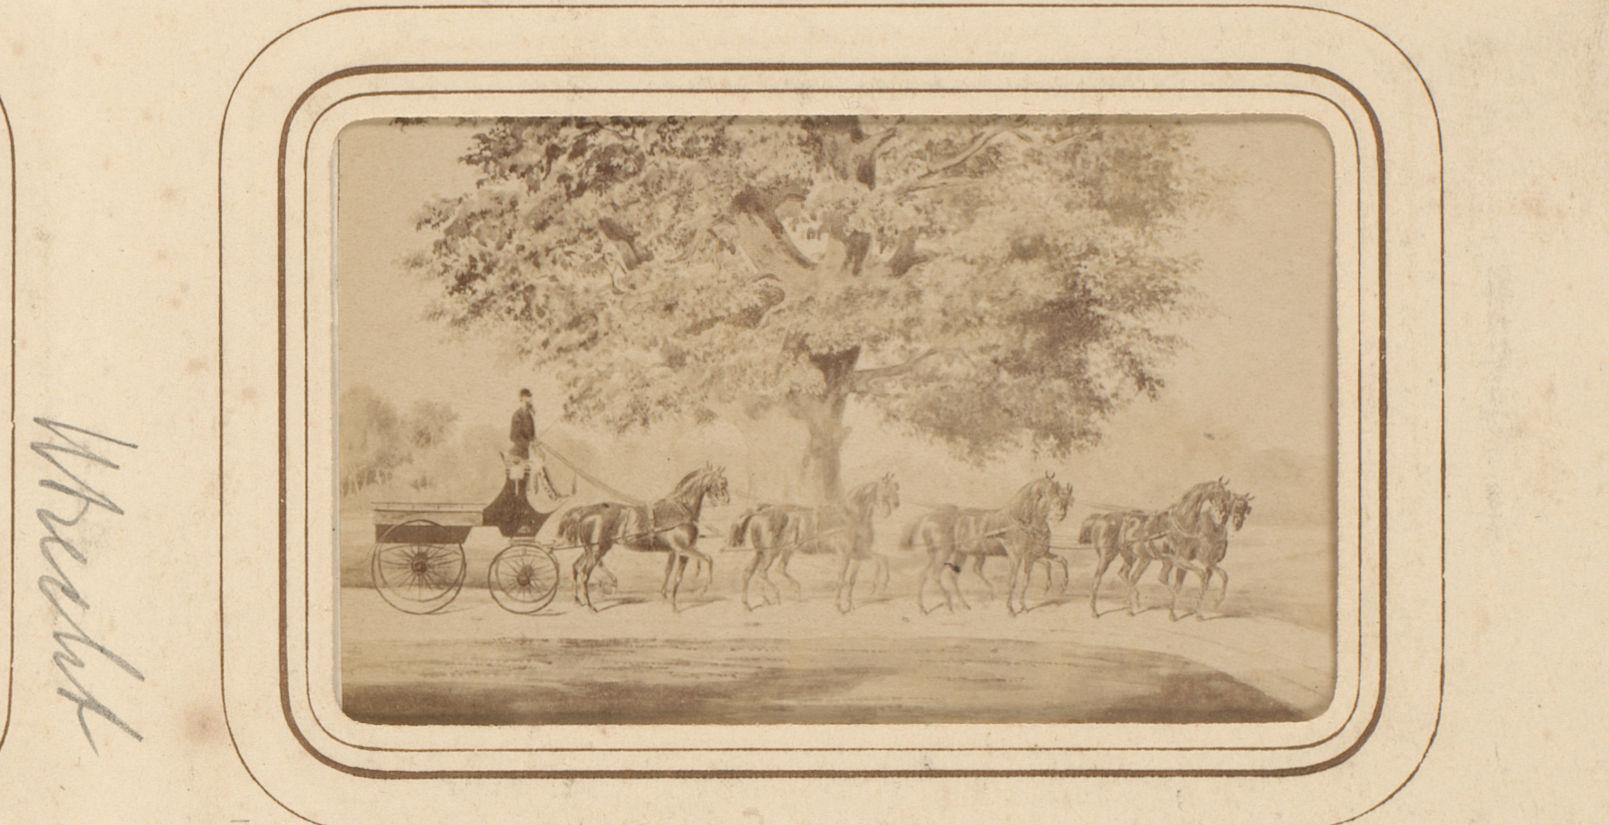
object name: photograph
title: Fotoreproductie van ontwerp met de voorstelling van een paardenkar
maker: Anonymous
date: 1865-1890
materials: cardboard, photographic support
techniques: albumen print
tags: four-wheeled, animal-drawn vehicle, e.g.: cab, carriage, coach, painting, drawing and the graphic arts